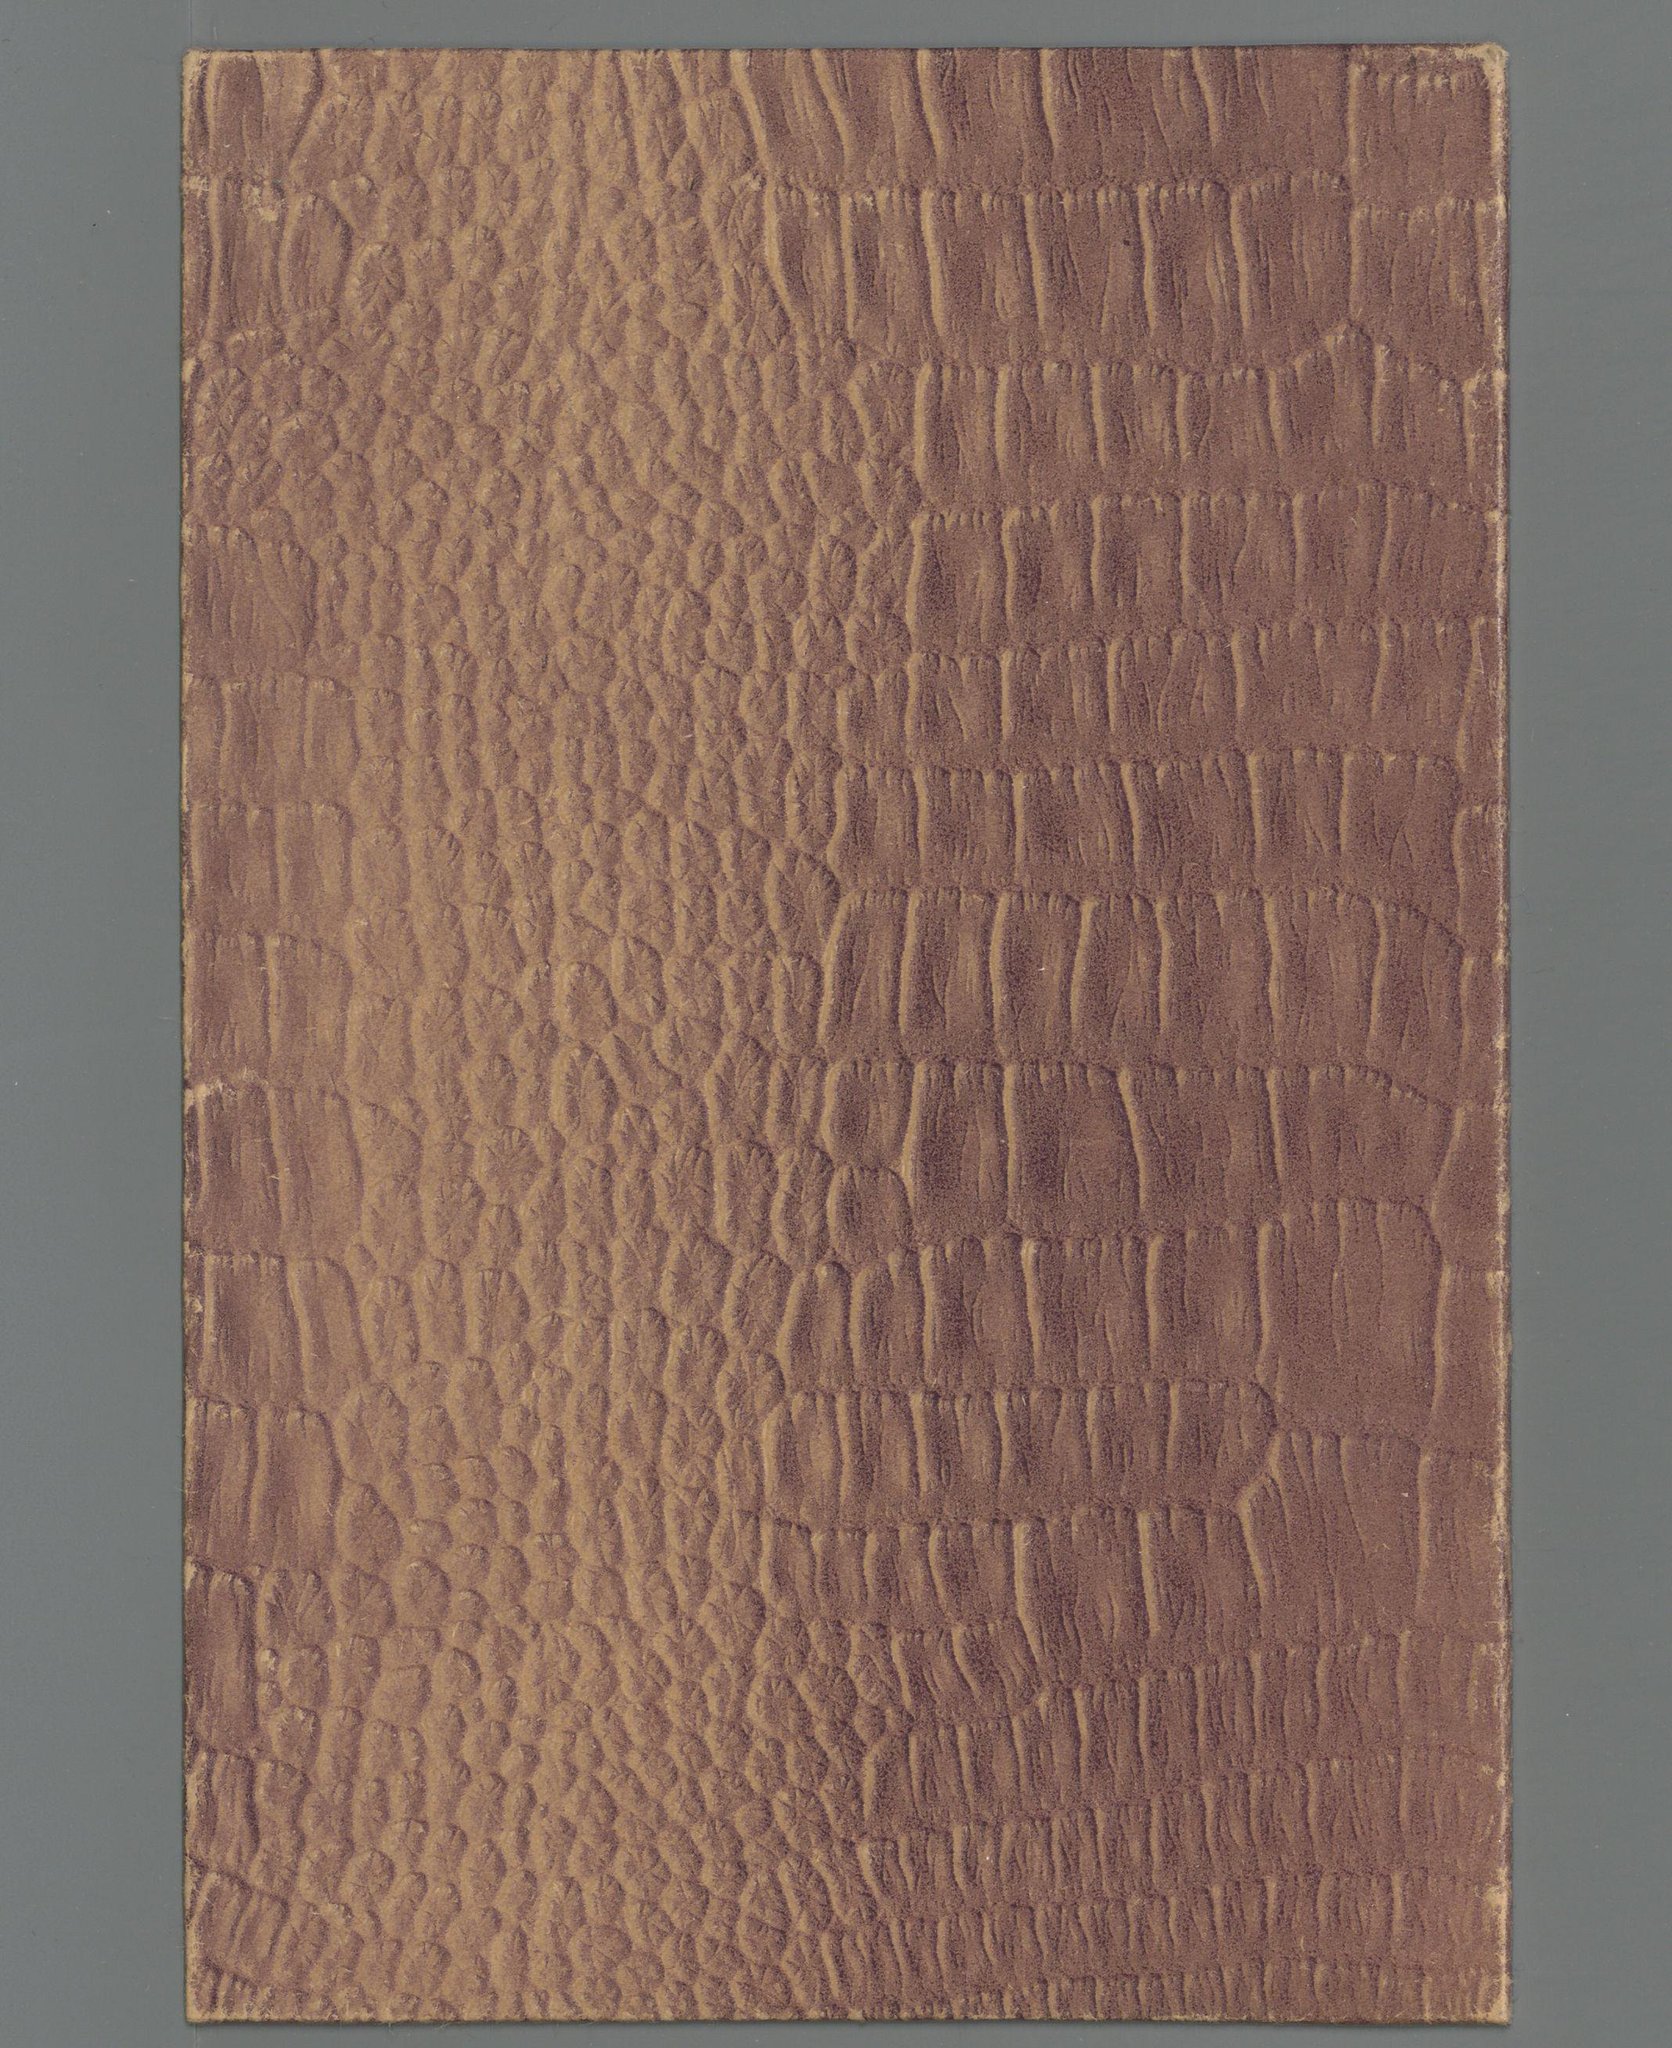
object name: wrapper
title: Omslag voor vierendertig prentbriefkaarten van Turijn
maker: Anonymous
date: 1900-1950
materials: cardboard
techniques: pasting